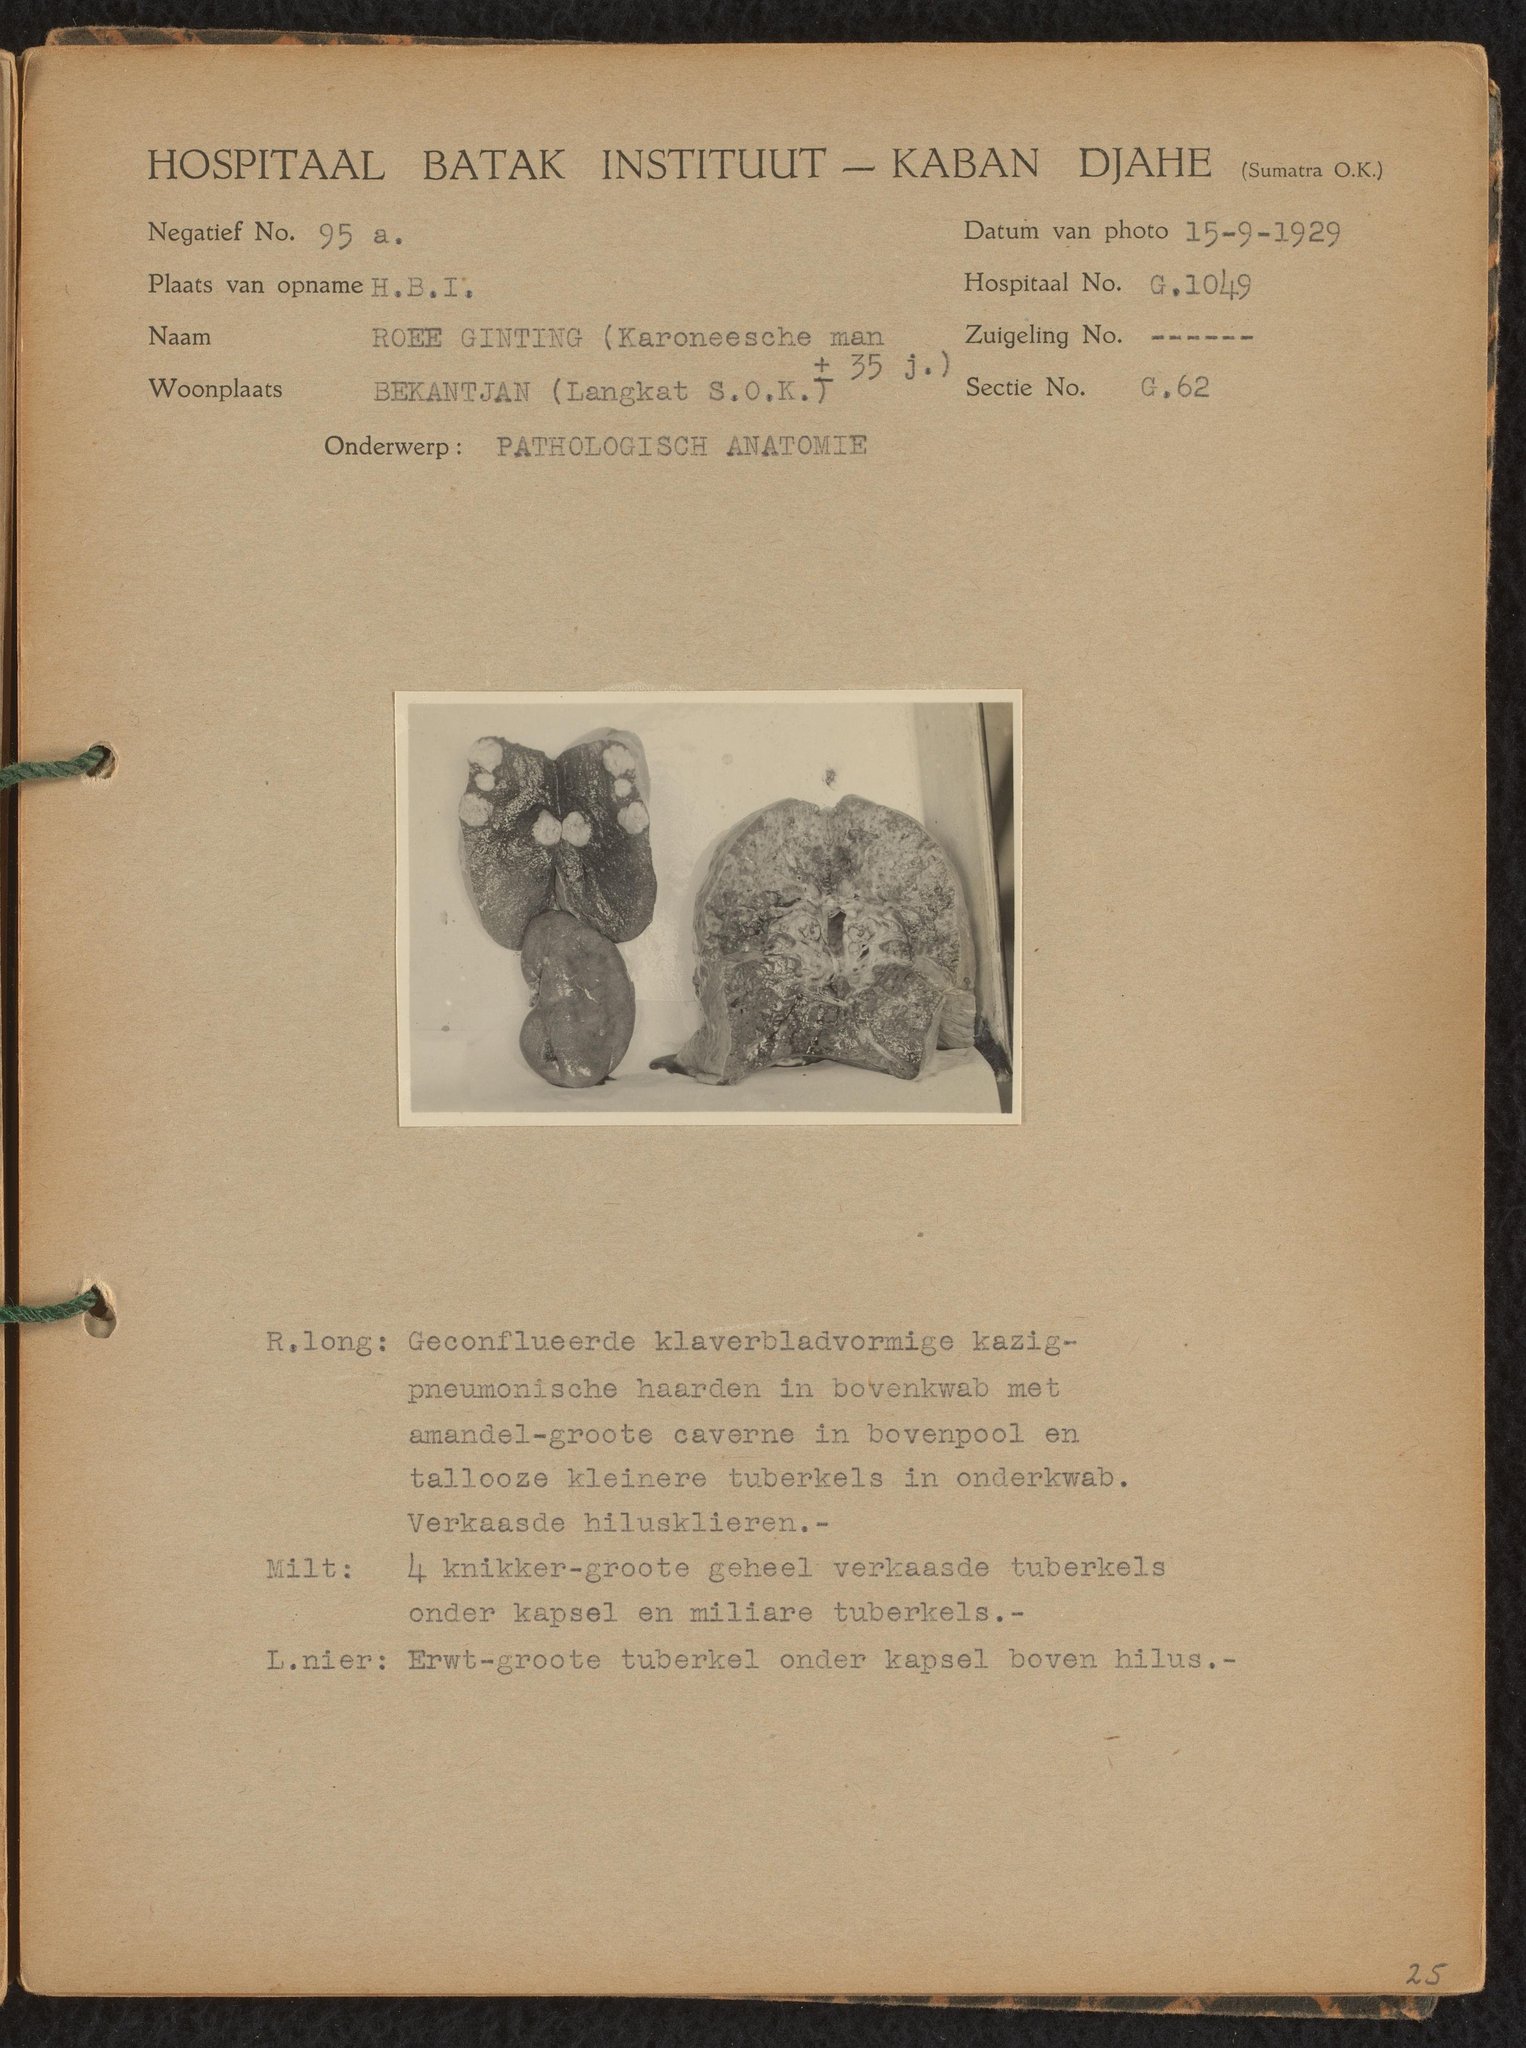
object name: photograph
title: Pathologische anatomie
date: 1929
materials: cardboard, photographic support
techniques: gelatin silver print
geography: kabanjahe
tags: colonial system, patient, sick person, anatomical specimen, sumatra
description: Medische foto van door ziekte aangetaste long, milt en nier van een man genaamd Roee Ginting van ca. 35 jaar, na sectie op de afdeling Pathologische anatomie. Datum foto: 15 september 1929. Foto geplakt op voorgedrukt kartonnen blad ingebonden in het fotoalbum over het Hospitaal Batak Instituut te Kabanjaheh op Sumatra in de jaren 1926-1929.